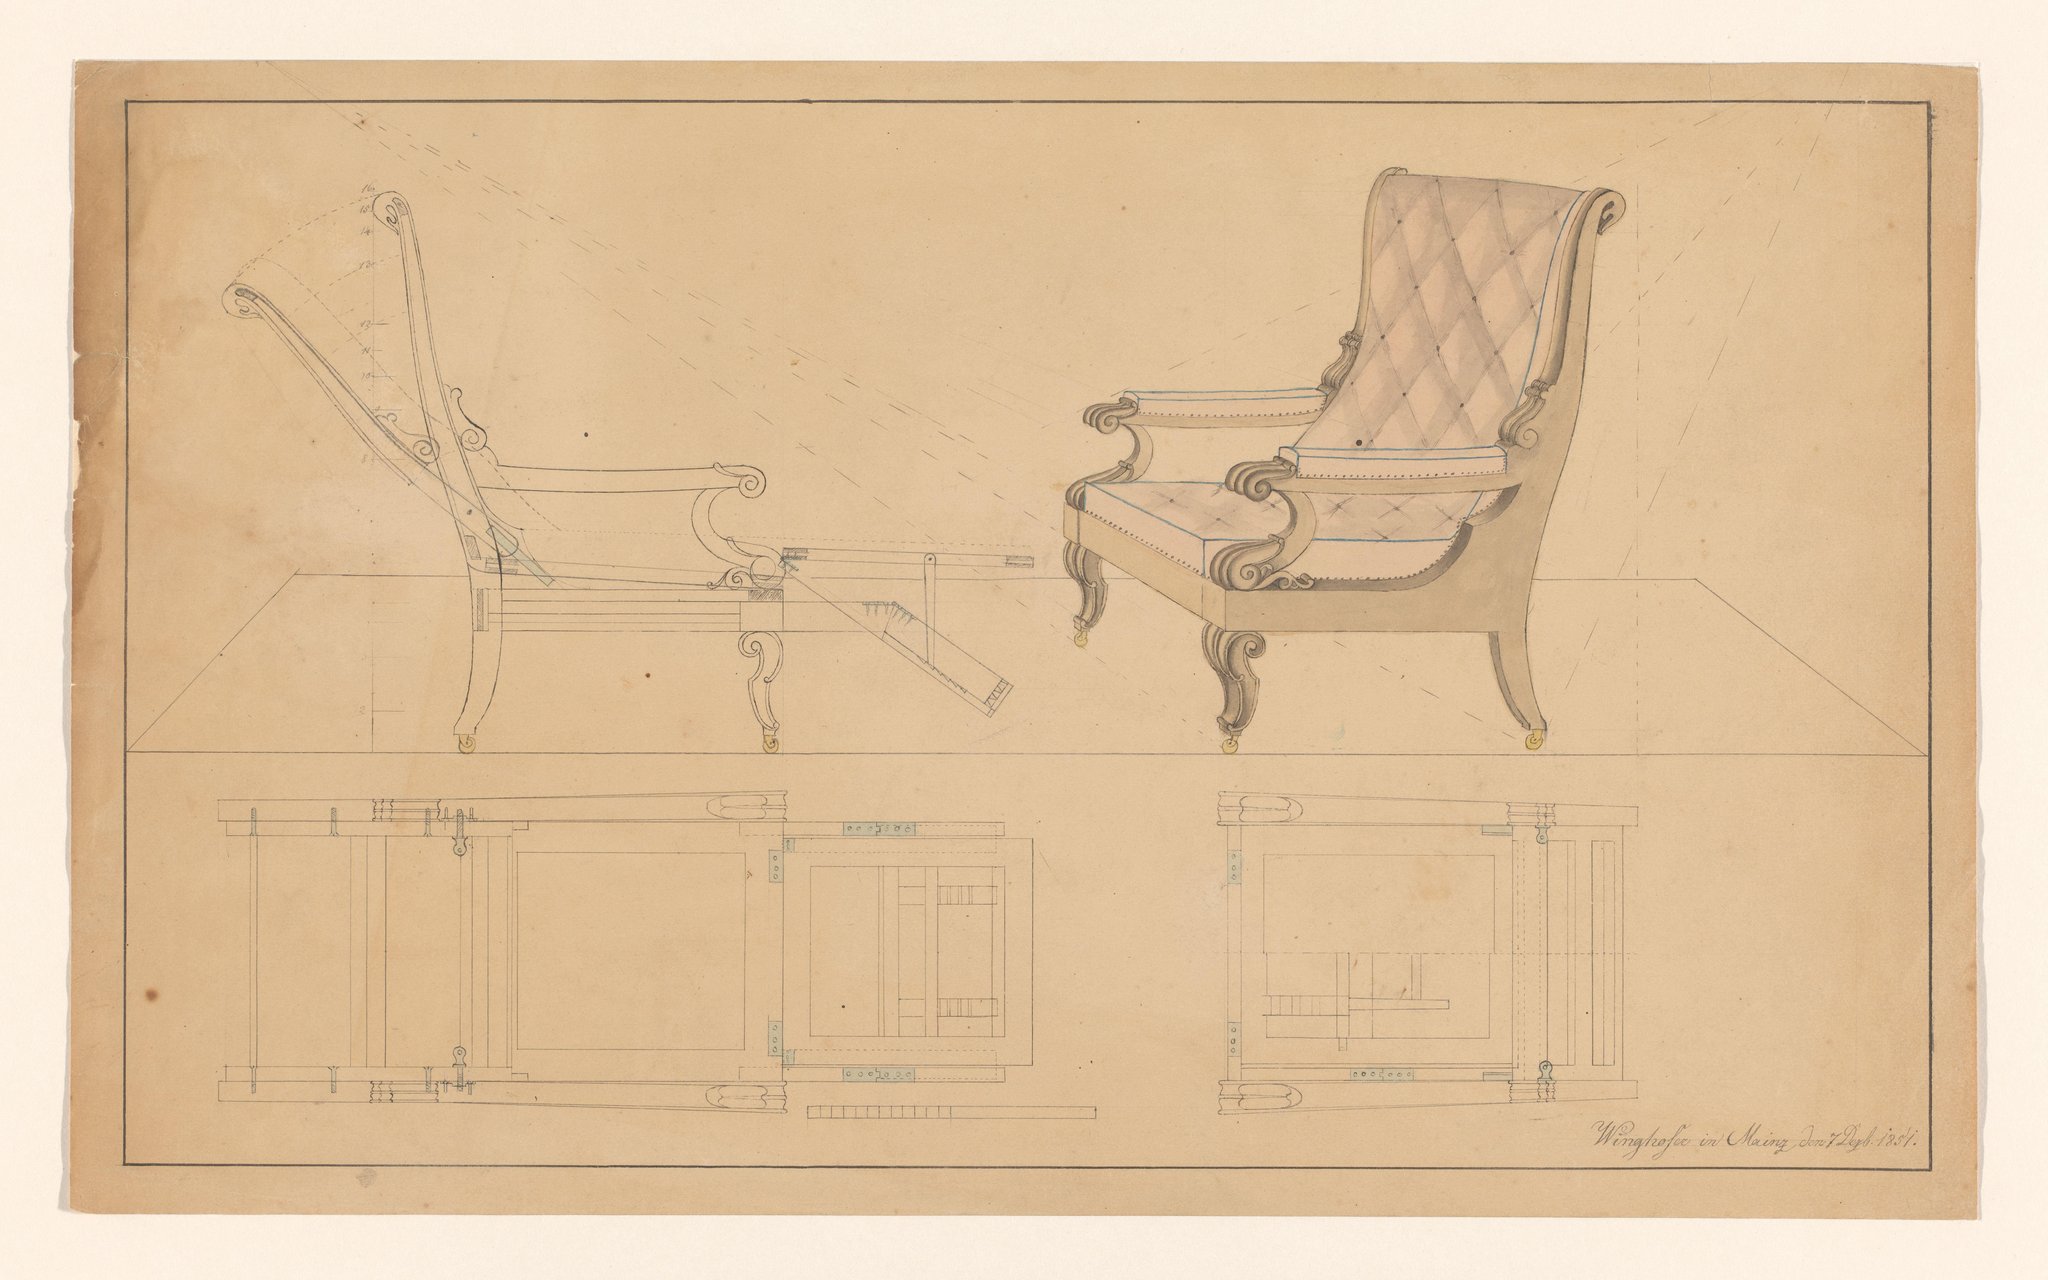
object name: drawing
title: Ontwerp voor een beklede armstoel met verstelbare rug en uitklapbare zitting, met zijaanzicht en plattegronden onder beide aanzichten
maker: b. winghofer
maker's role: draughtsman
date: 1851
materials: graphite, ink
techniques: drawing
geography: mainz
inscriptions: signature and date: ‘Winghofer in Mainz den 7 Dezb. 1851’, size: ‘Van linker aanzicht maatstaf met 2 3 8 9 10 11 12 13 14 15 16’, size: ‘maatstaf’